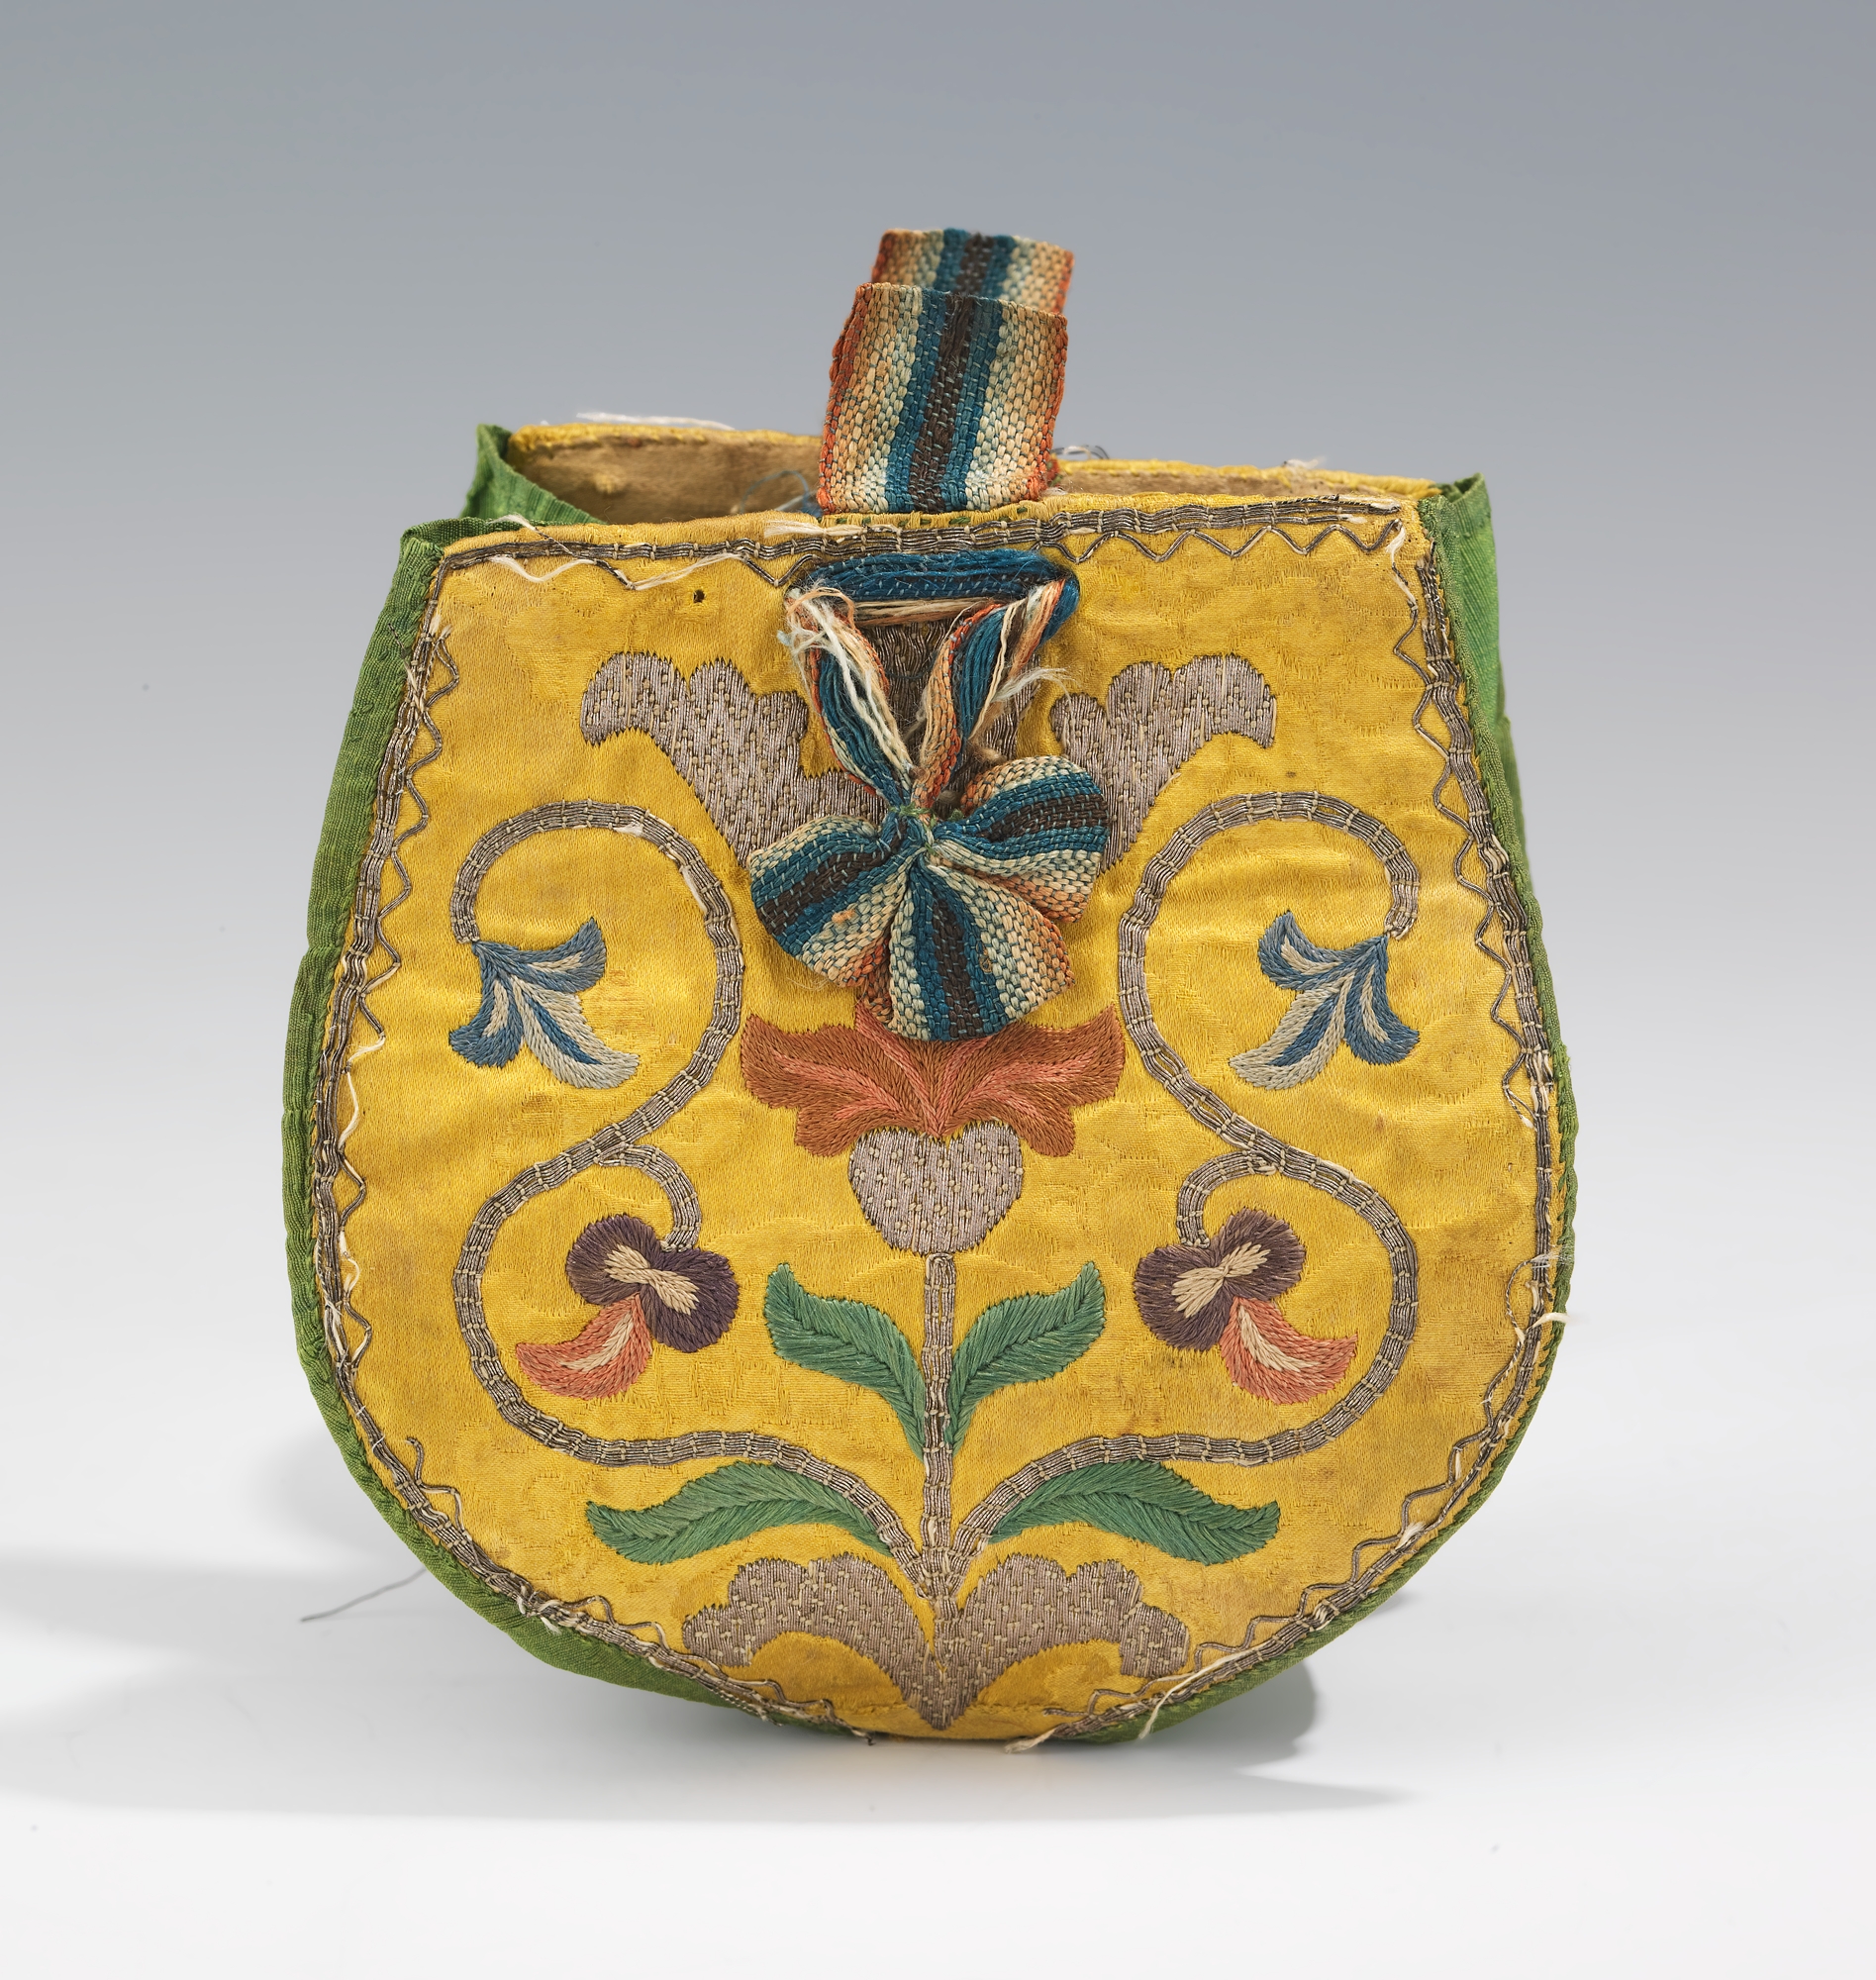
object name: pouch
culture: russian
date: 1730-1760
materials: metal, silk